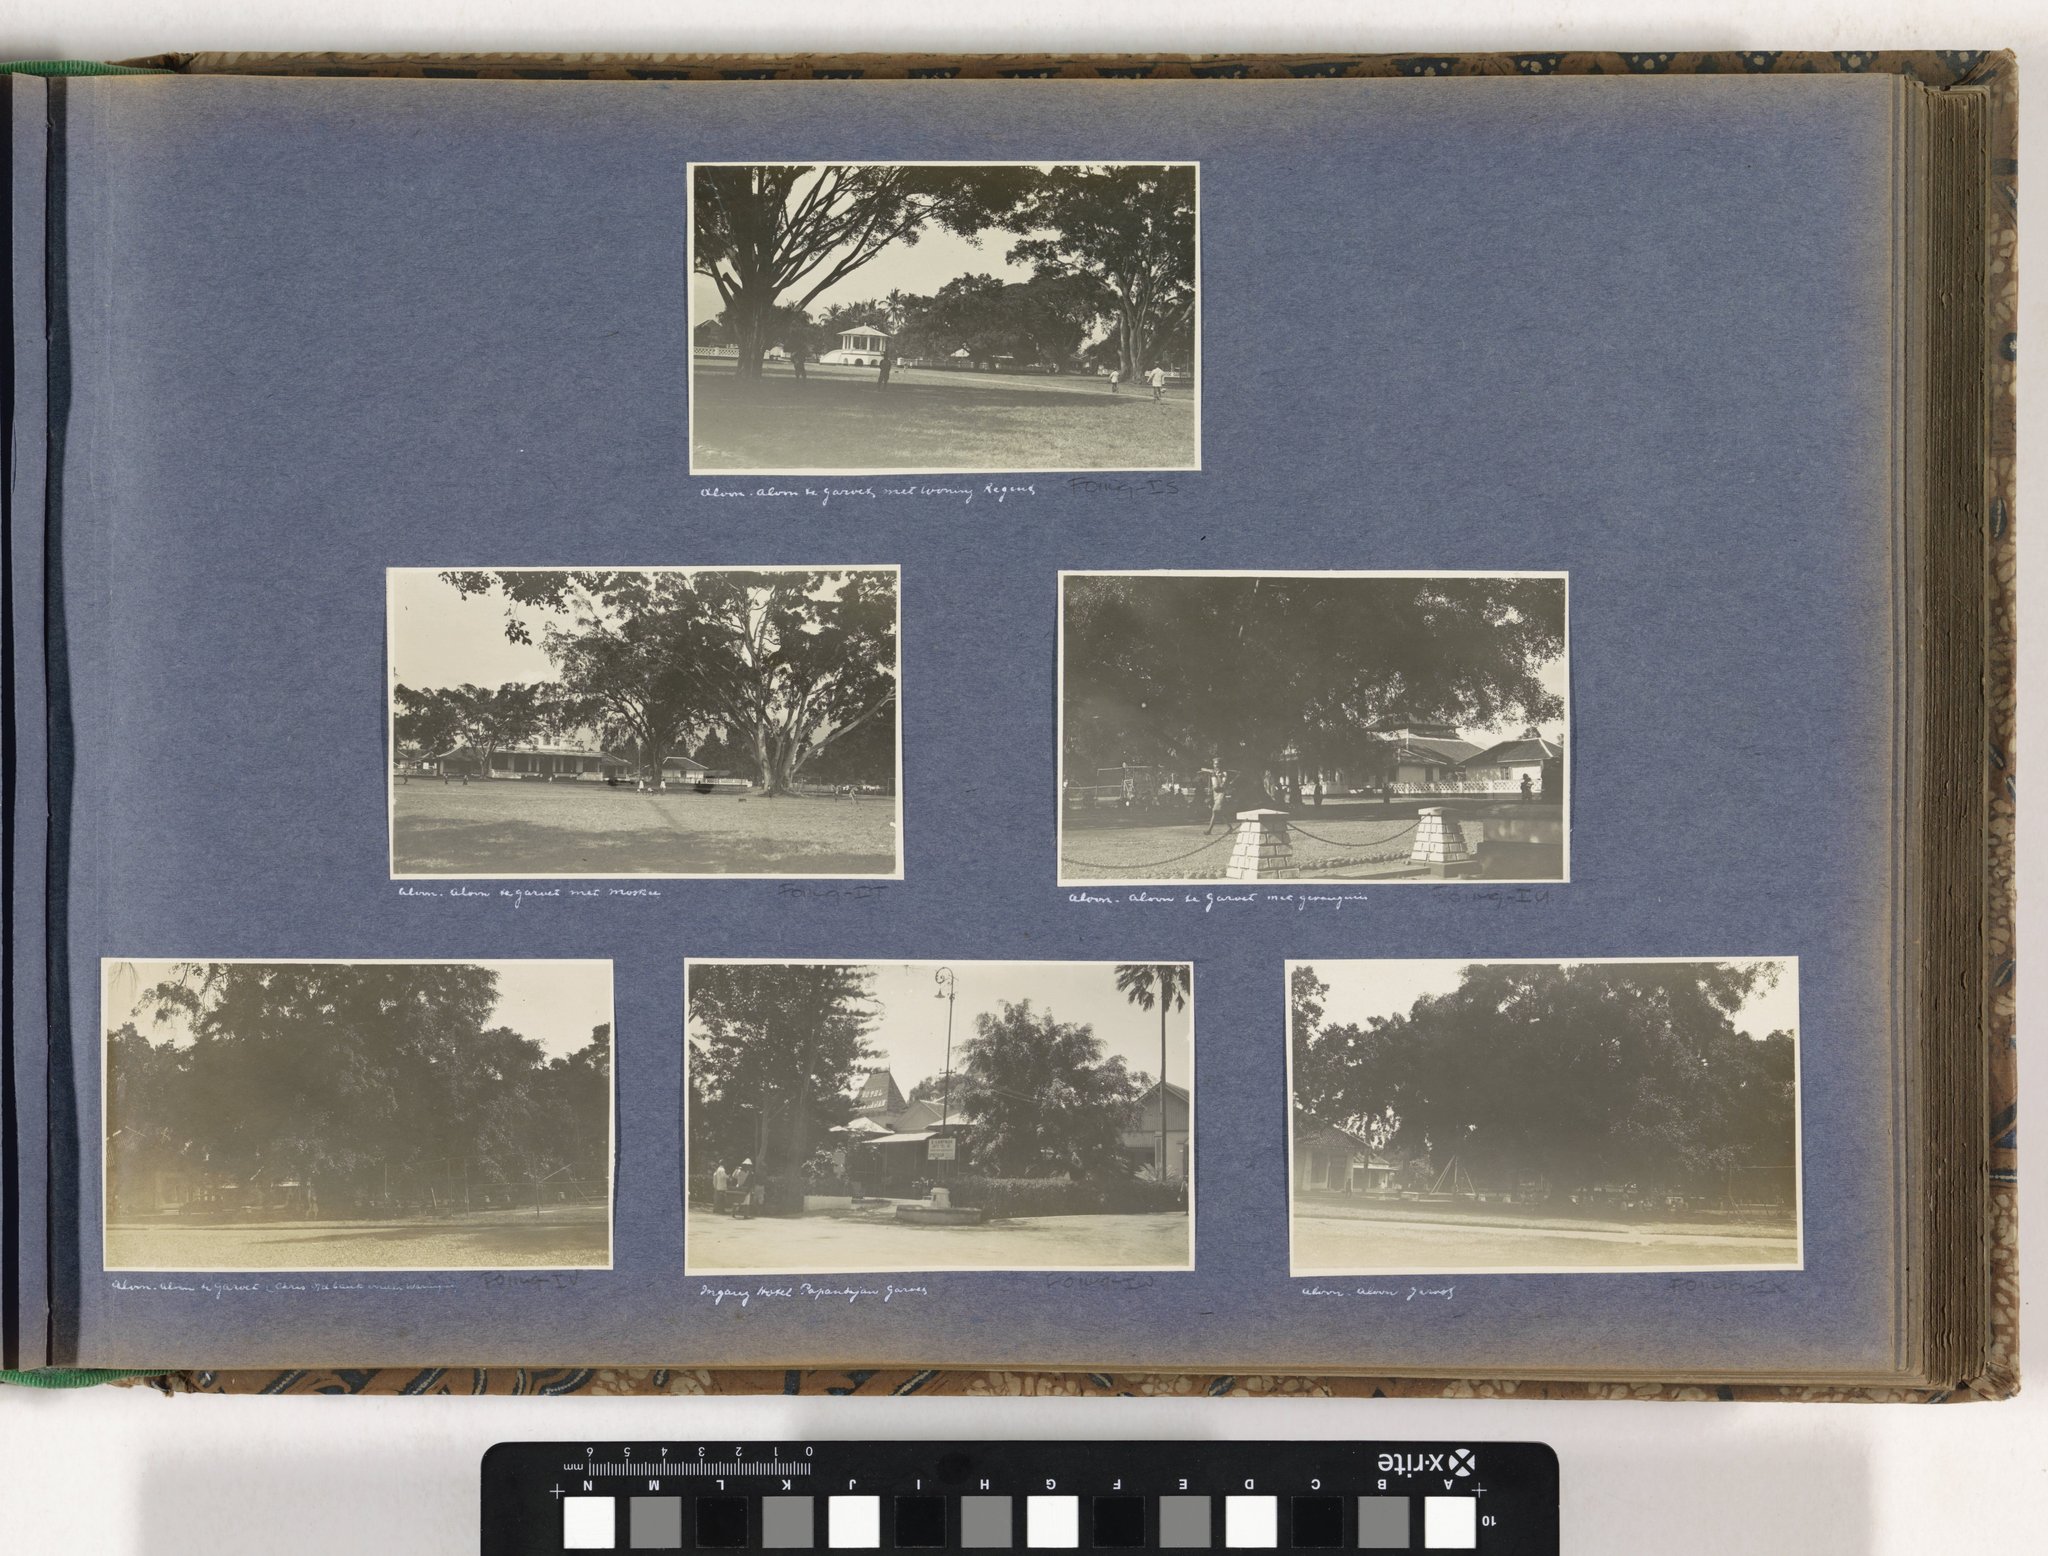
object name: photograph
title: Grasveld (alun-alun) met gebouwen onder bomen in Garut op Java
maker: Anonymous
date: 1900-1920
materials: paper, photographic support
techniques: gelatin silver print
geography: garut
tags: lawn, square, place, circus, etc. (+ city(-scape) with figures, staffage)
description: Onderdeel van reisalbum met foto's van bedrijvigheid en bezienswaardigheden op Sumatra en Java en van de reis naar en van Nederlands-Indië.